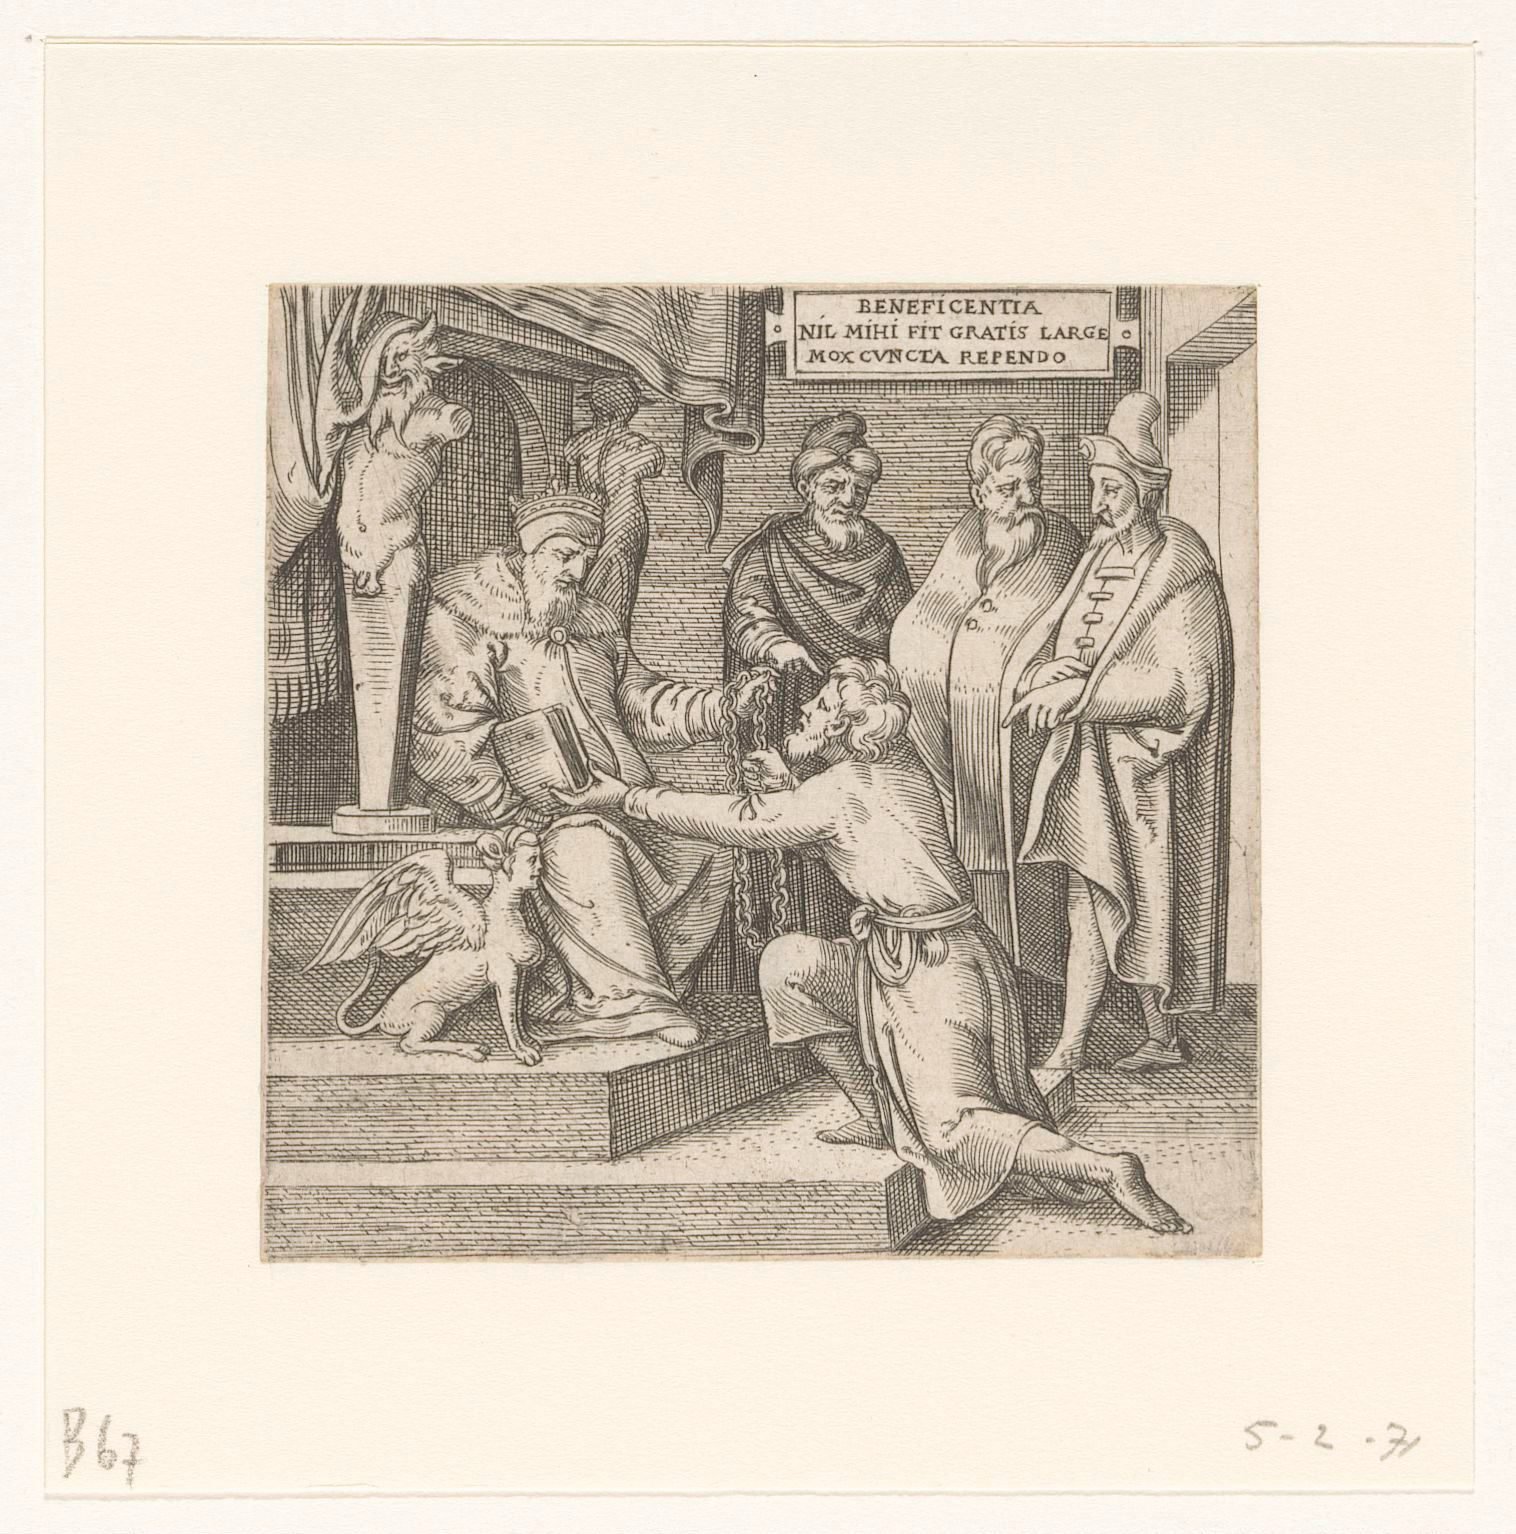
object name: print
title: Weldaad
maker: francesco salviati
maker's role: draughtsman, painter, print maker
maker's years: 1510-1563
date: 1533-1567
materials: paper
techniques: engraving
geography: italy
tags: granting mercy; free pardon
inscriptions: collector's mark: Lugt 2166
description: Een koning zit op zijn troon en bevrijdt een gevangene die voor hem knielt. Drie mannen staan toe te kijken. Titel en twee regels Latijnse tekst in een cartouche rechtsboven.